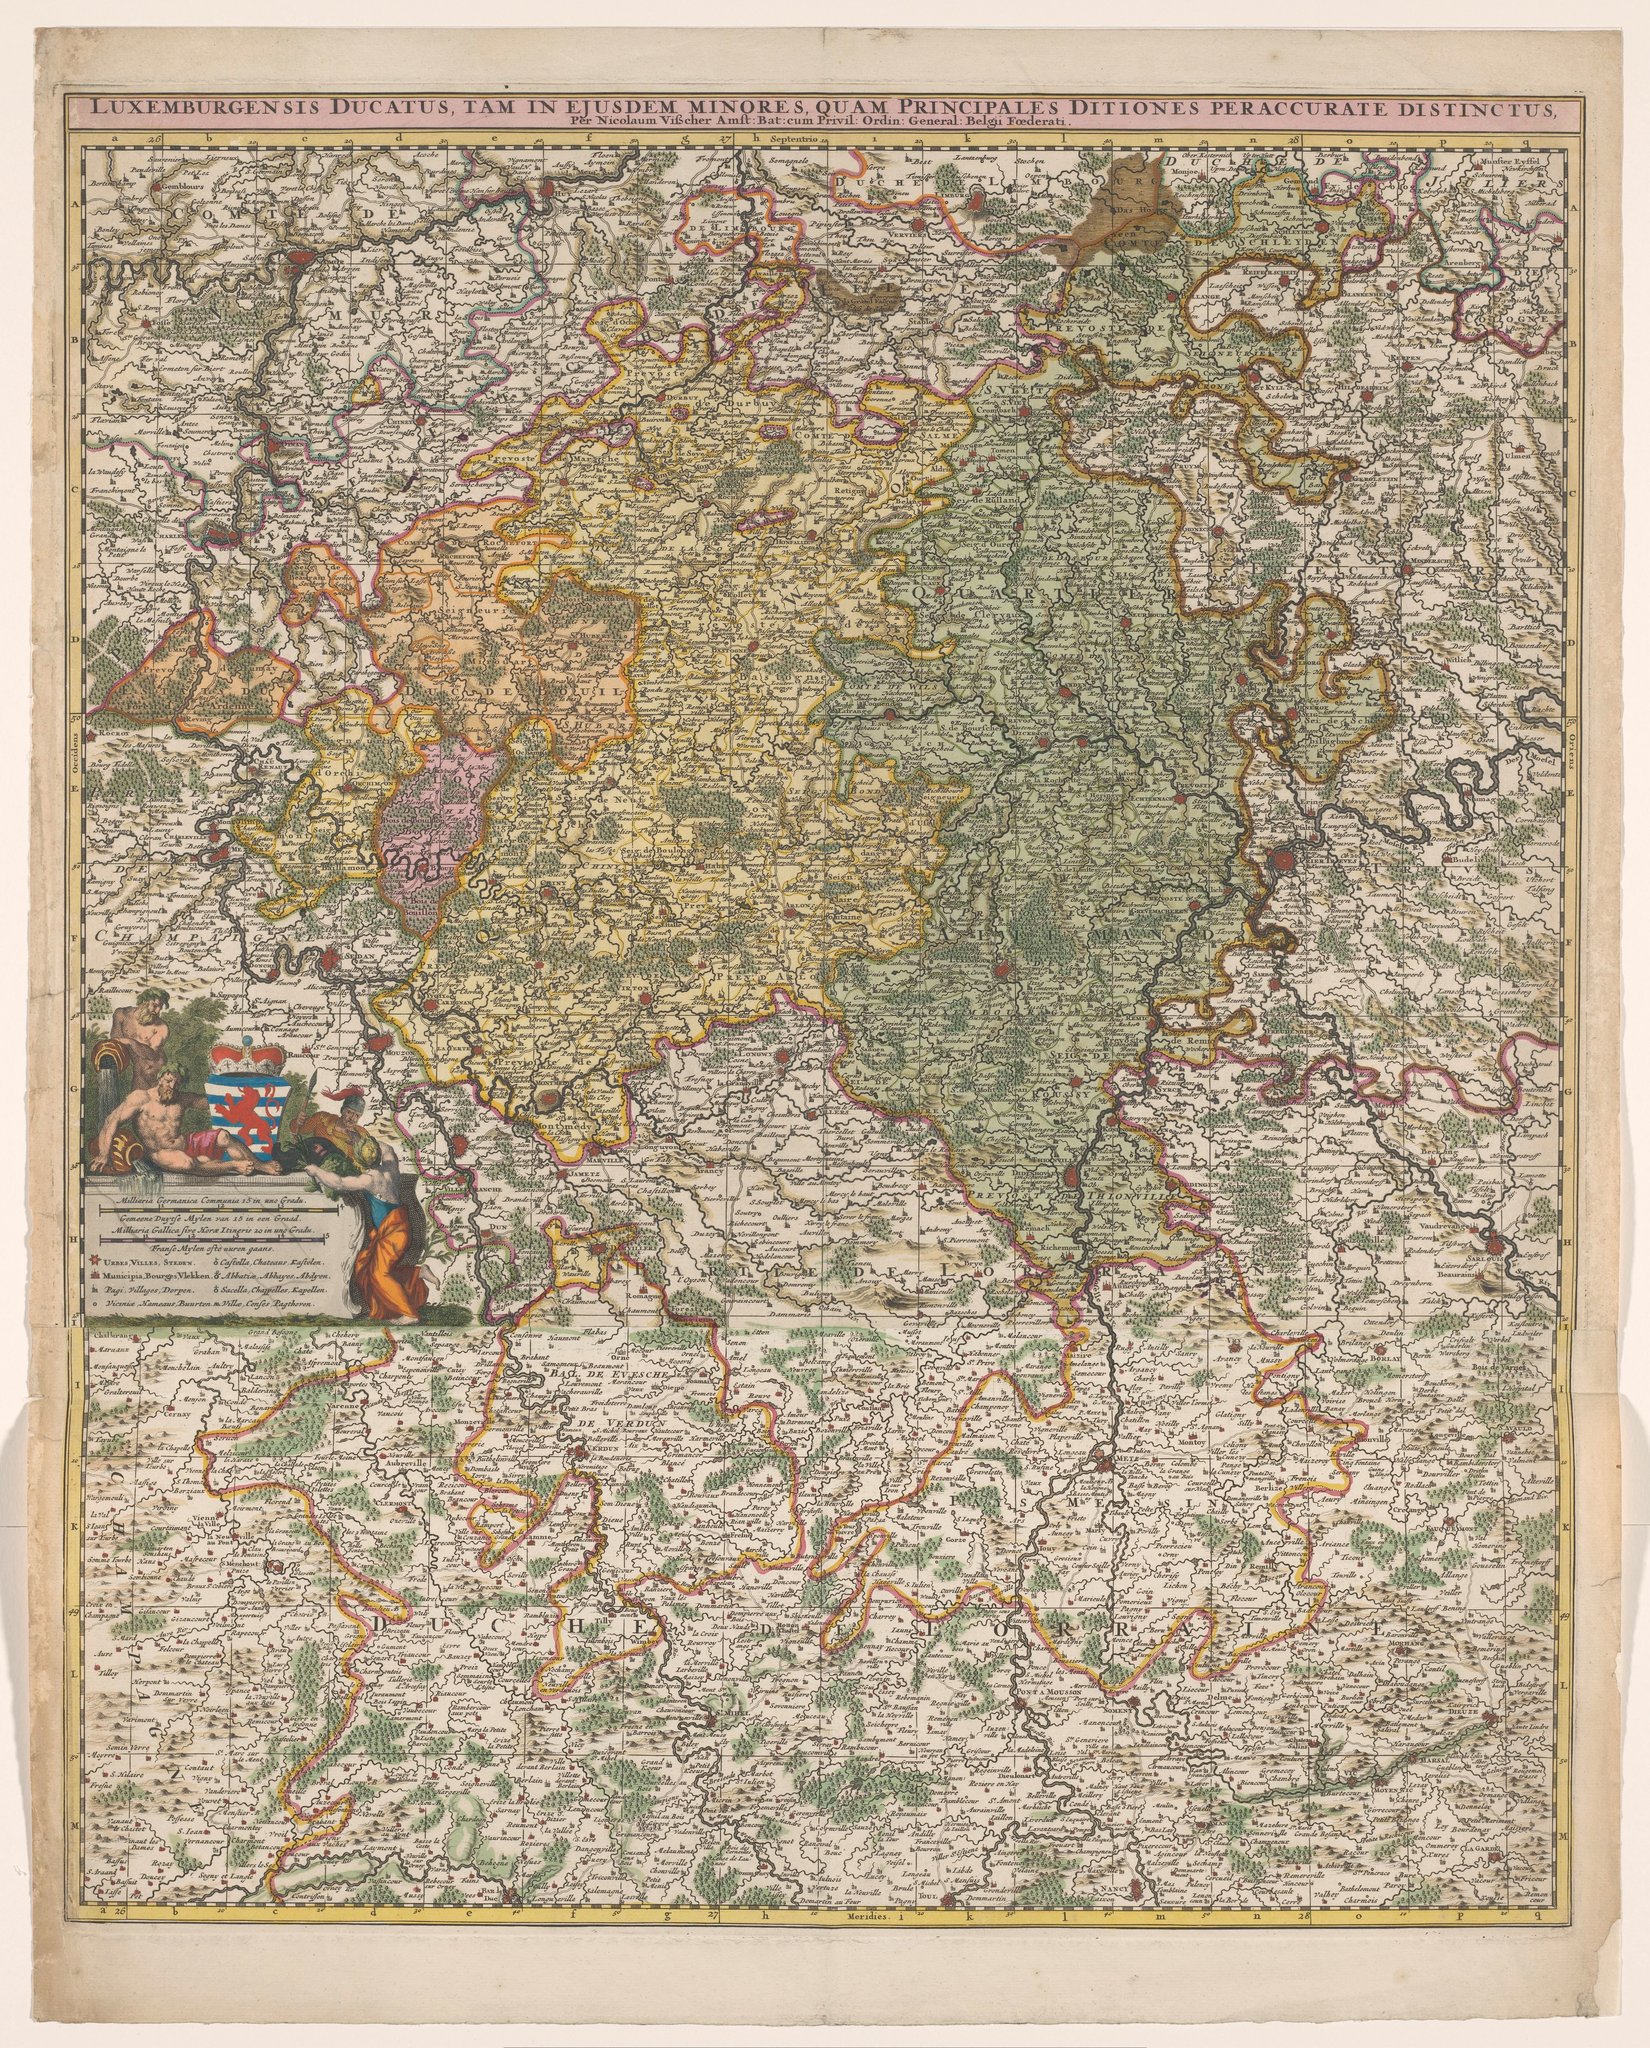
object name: map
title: Luxemburgensis ducatus, tam in ejusdem minores, quam principales (...)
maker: Anonymous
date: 1677-1720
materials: paper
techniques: engraving, etching, hand coloring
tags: maps of separate countries or regions, river personified, 'fiumi' (ripa) - hh - ideal landscapes, coat of arms (as symbol of the state, etc.) (+ province; provincial)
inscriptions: collector's mark: Lugt 2228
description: Kaart van het hertogdom Luxemburg. De titel in een balk boven de kaart. Linksonder een cartouche met legenda en twee schaalstokken: 4 Gemeene Duytse Mylen van 15 in een Graad / 5 Franse Mylen ofte uuren gaans. Boven de cartouche het wapen van het hertogdom Luxemburg. De kaart is voorzien van een zoekrooster en een gradenverdeling langs de randen.